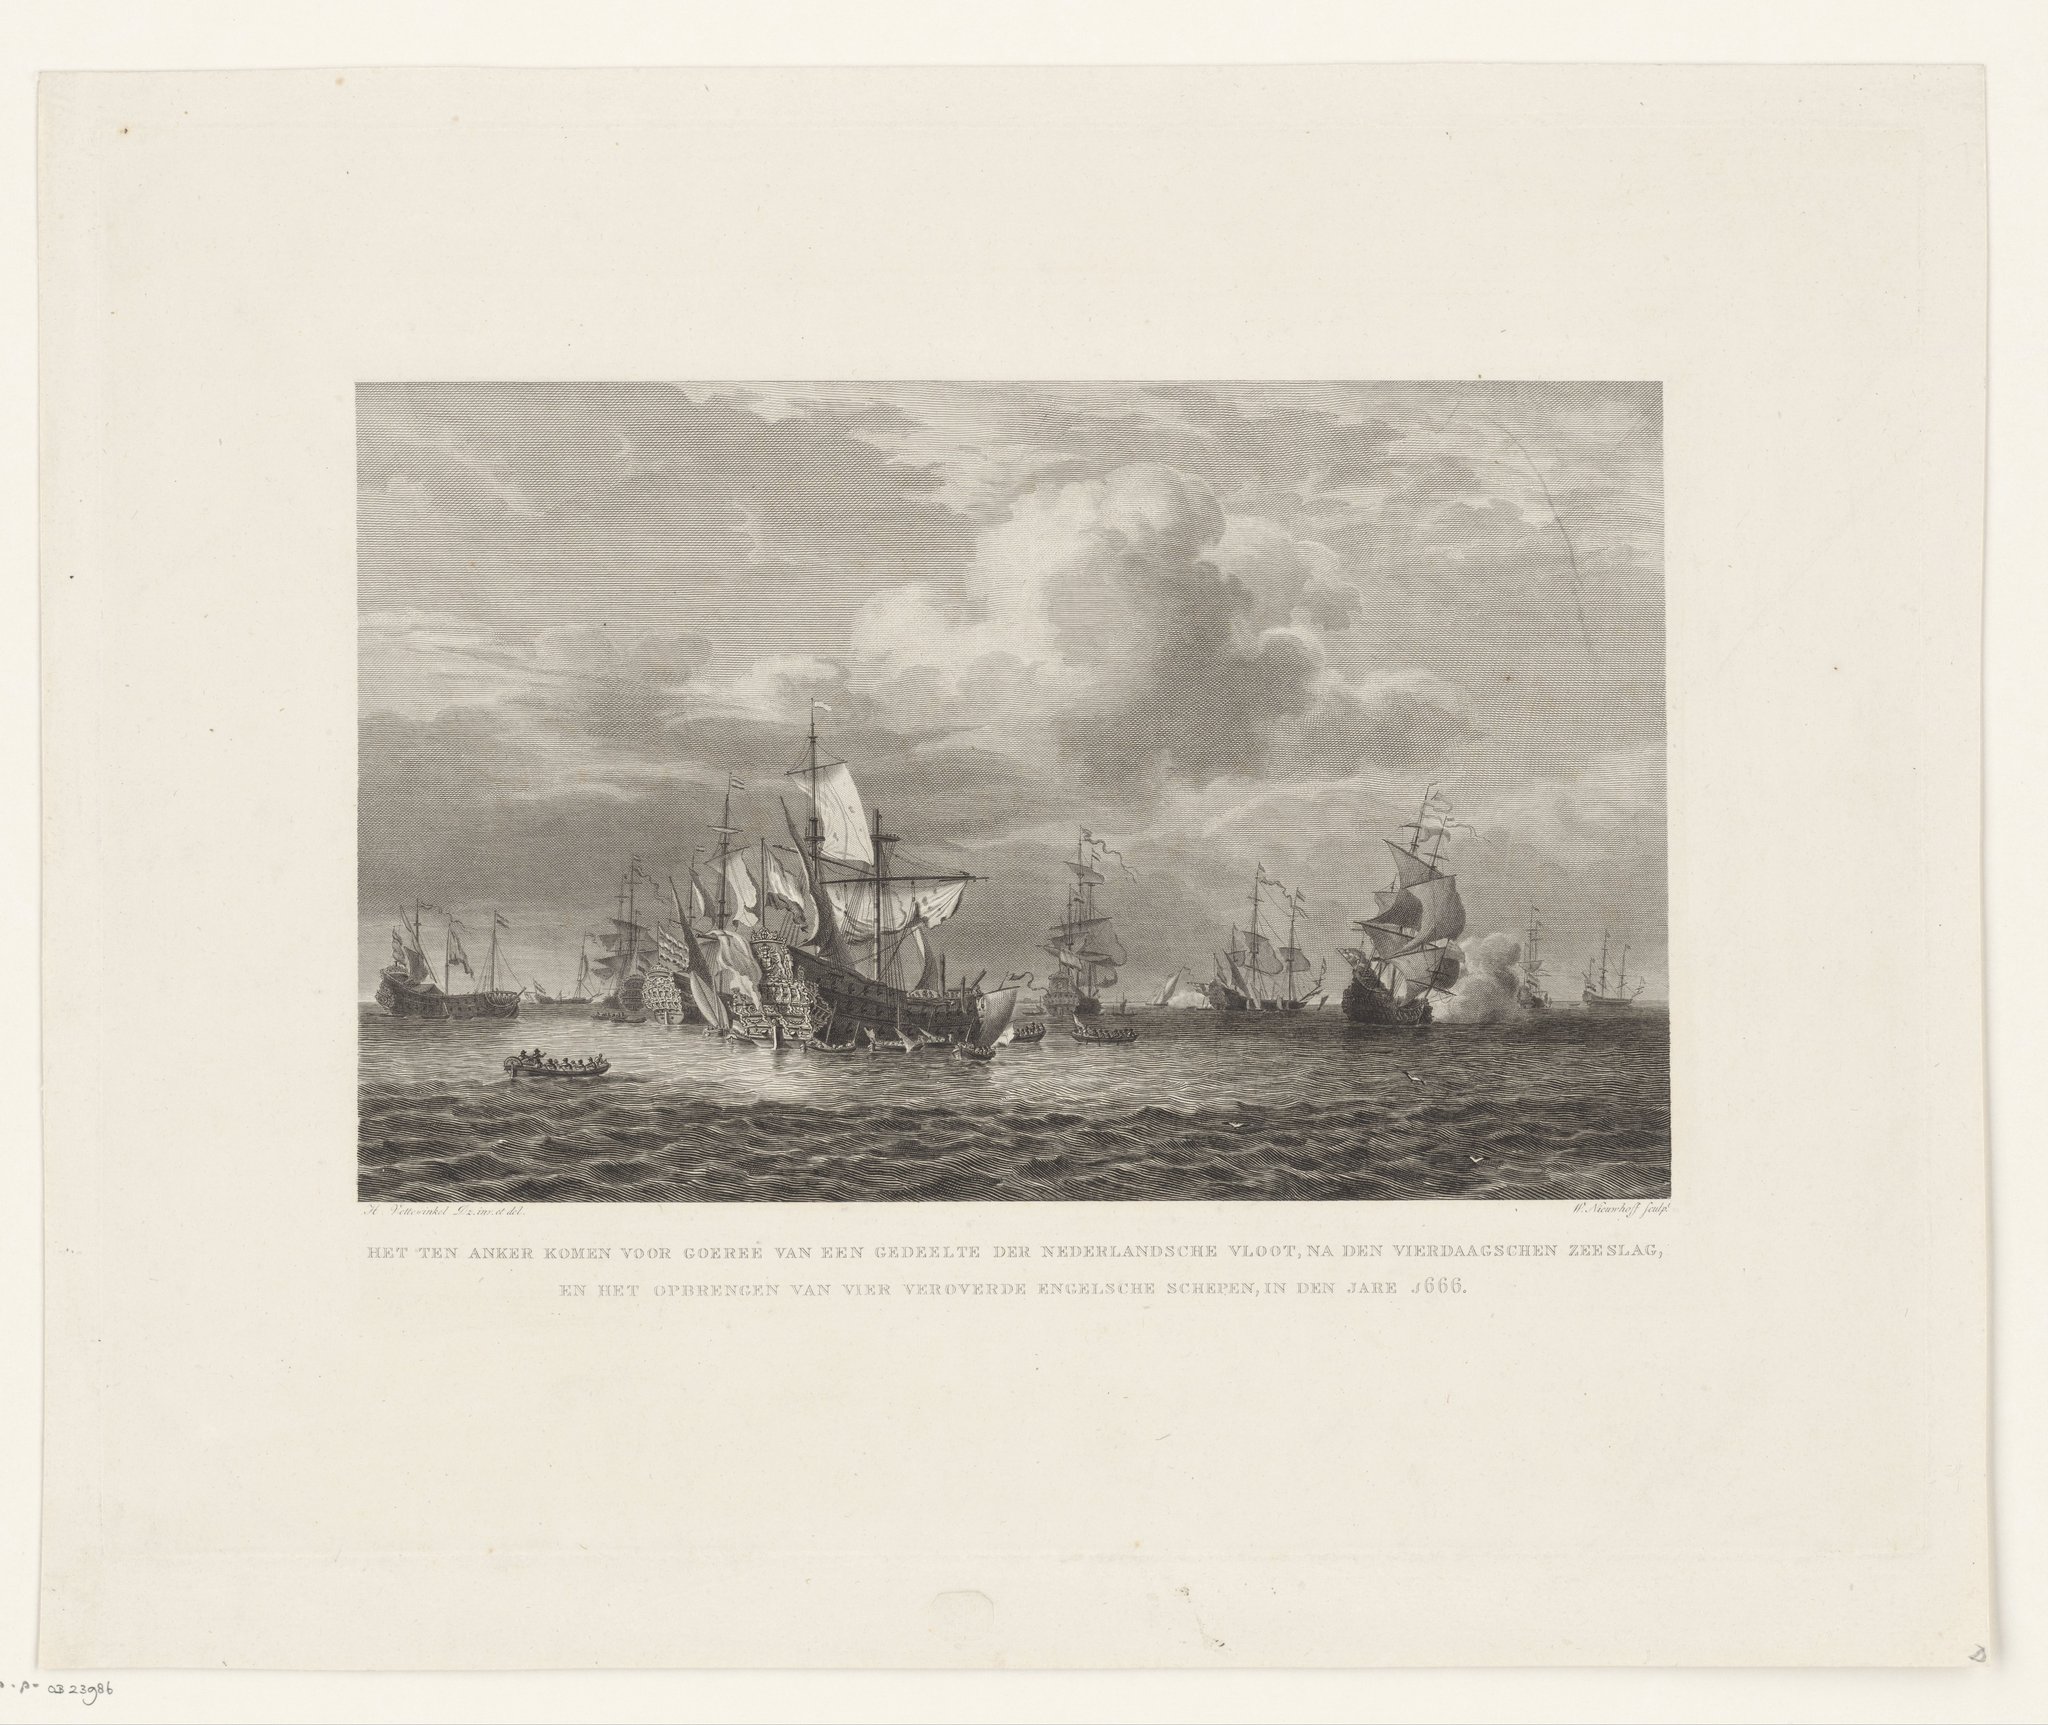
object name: print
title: Nederlandse vloot voor Goeree na de Vierdaagse Zeeslag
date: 1800-1837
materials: paper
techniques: engraving, etching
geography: amsterdam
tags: damage (to a ship), battle (+ naval force)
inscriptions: collector's mark: Lugt 2228, collector's mark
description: Een deel van de Nederlandse vloot komt aan voor Goeree na de Vierdaagse Zeeslag in 1666, die onderdeel was van de Tweede Engelse Zeeoorlog. Daarbij zijn ook vier buitgemaakte Engelse schepen.